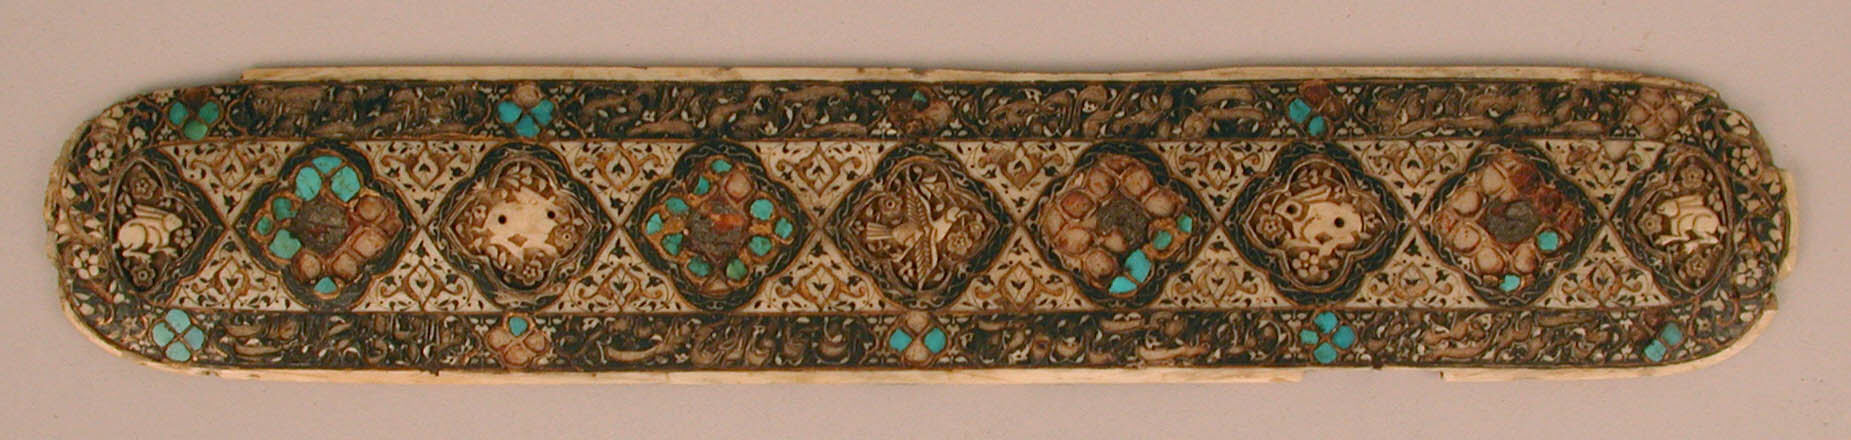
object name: cover of a pen box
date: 1601-1700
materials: ivory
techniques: carving, inlay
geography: india